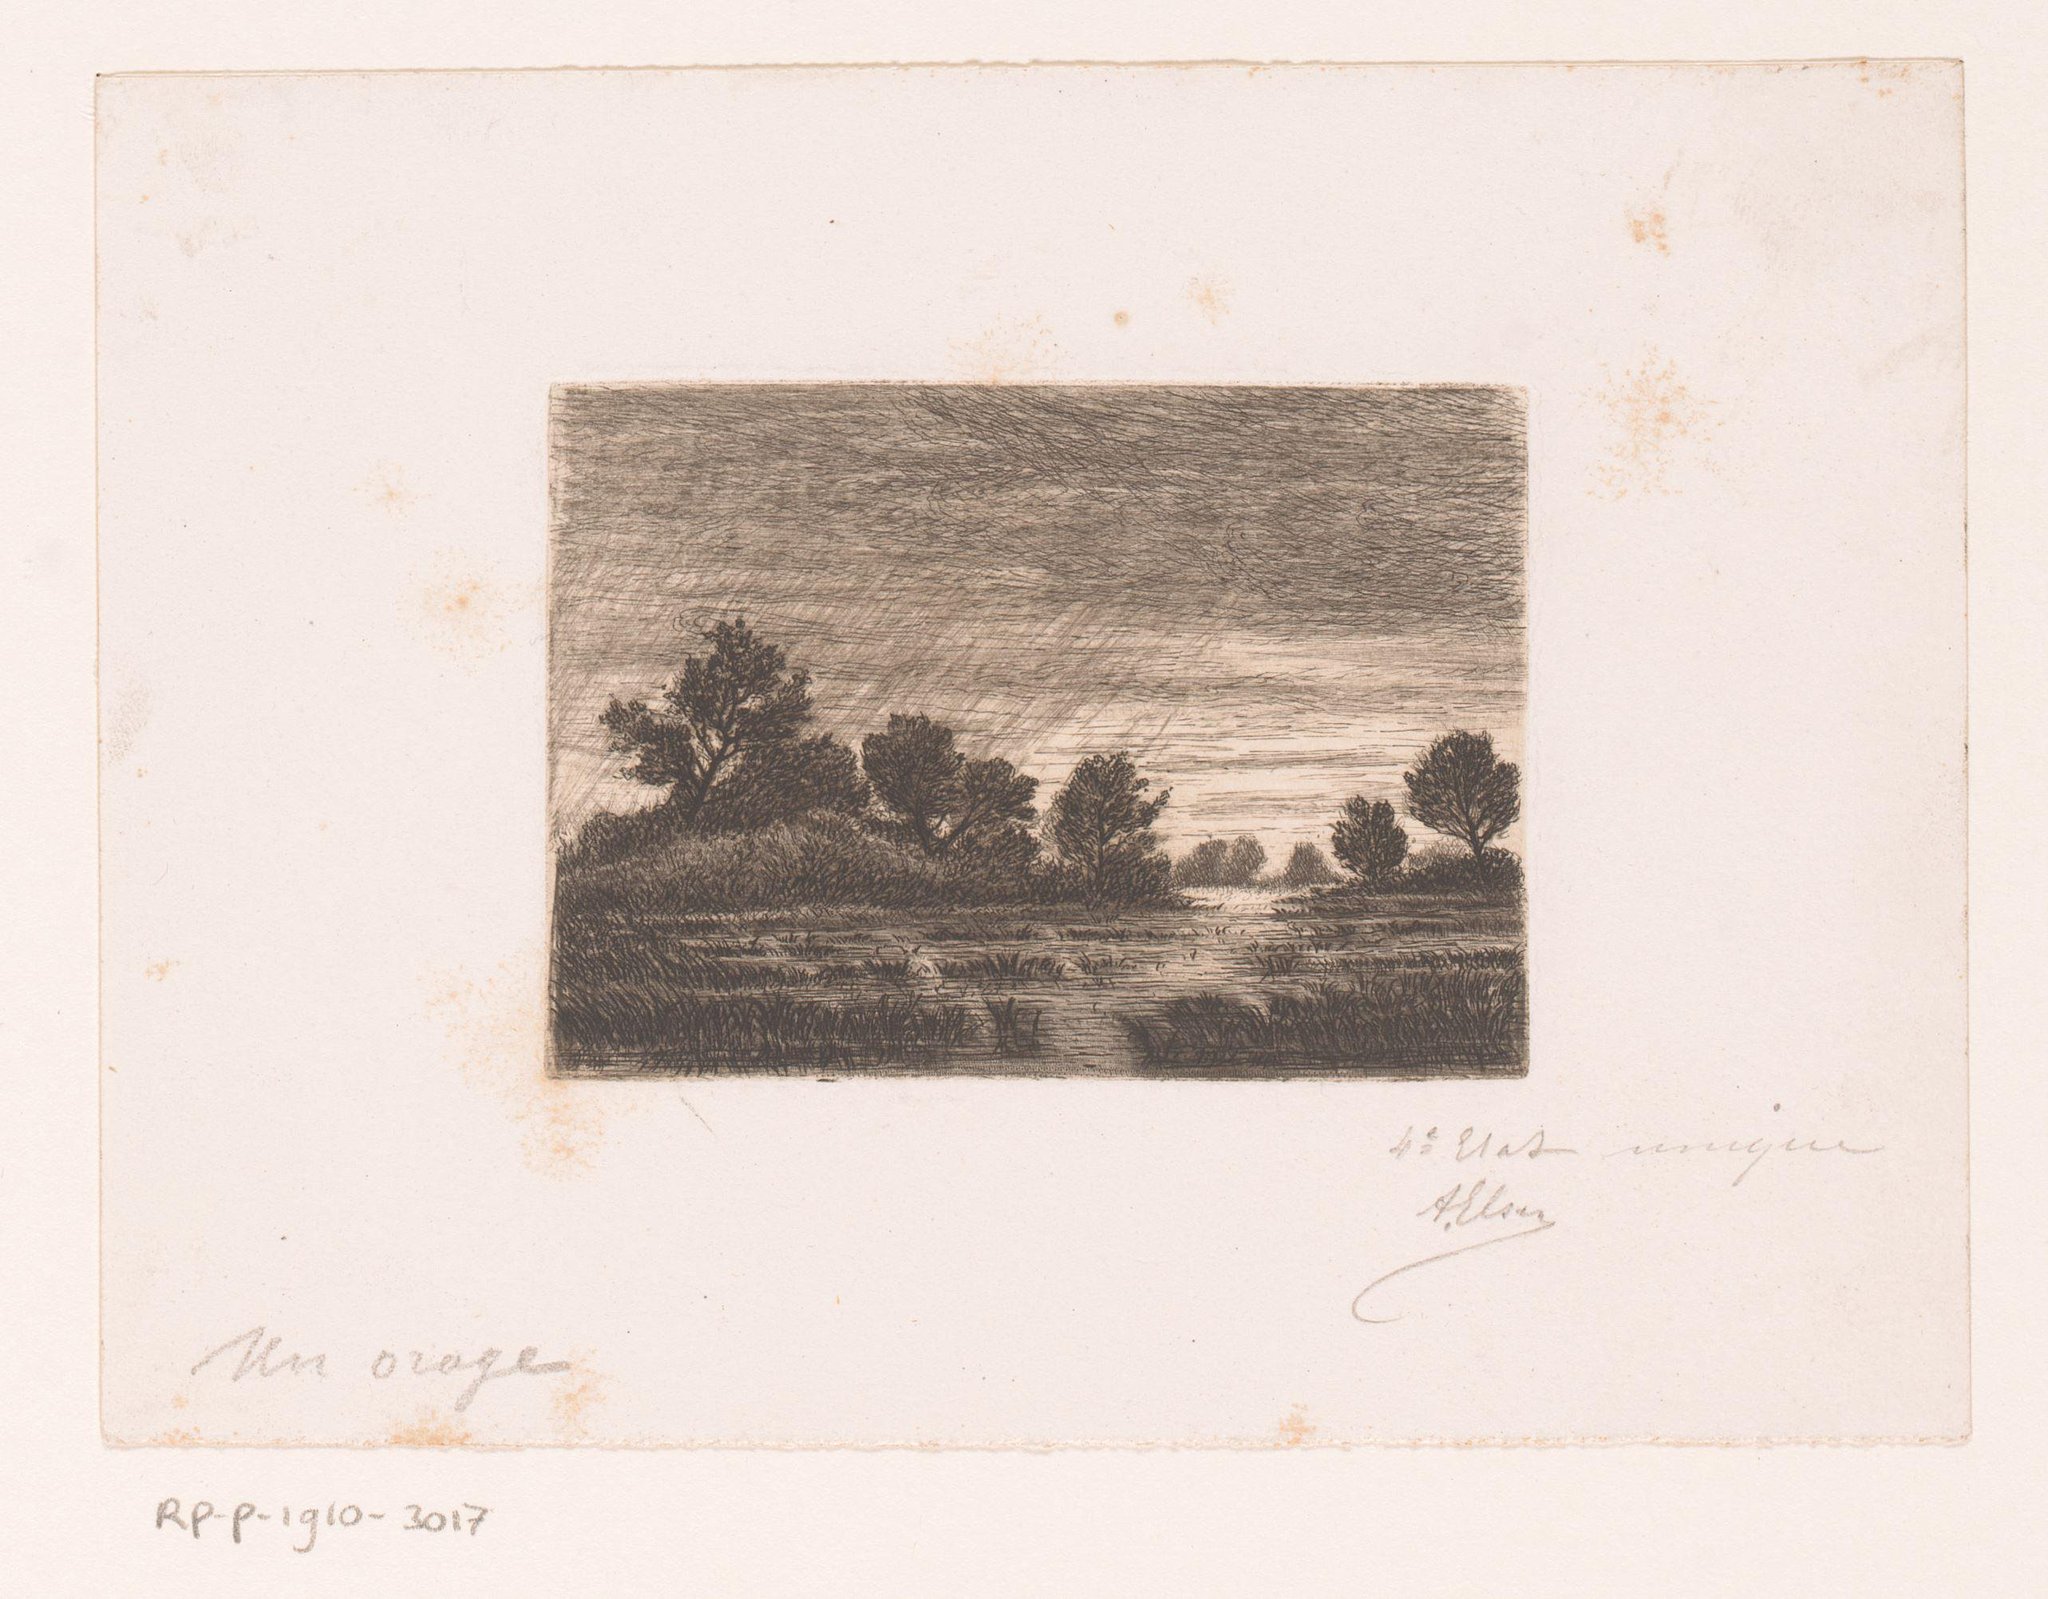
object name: print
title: Landschap met regenbui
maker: alfred elsen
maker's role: painter, print maker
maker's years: 1850-1914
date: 1860-1910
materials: paper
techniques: etching, intaglio, roulette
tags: downpour, rain shower, landscapes with waters, waterscapes, seascapes (in the temperate zone)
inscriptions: collector's mark: Lugt 2228, inscription: ‘4e Etat unique’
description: Er bevinden zich vier afdrukken van deze prent in de collectie van het Rijksmuseum. Deze vier afdrukken lijken allemaal dezelfde staat, maar de opschriften in potlood geven aan dat het zou gaan om vier unieke staten.